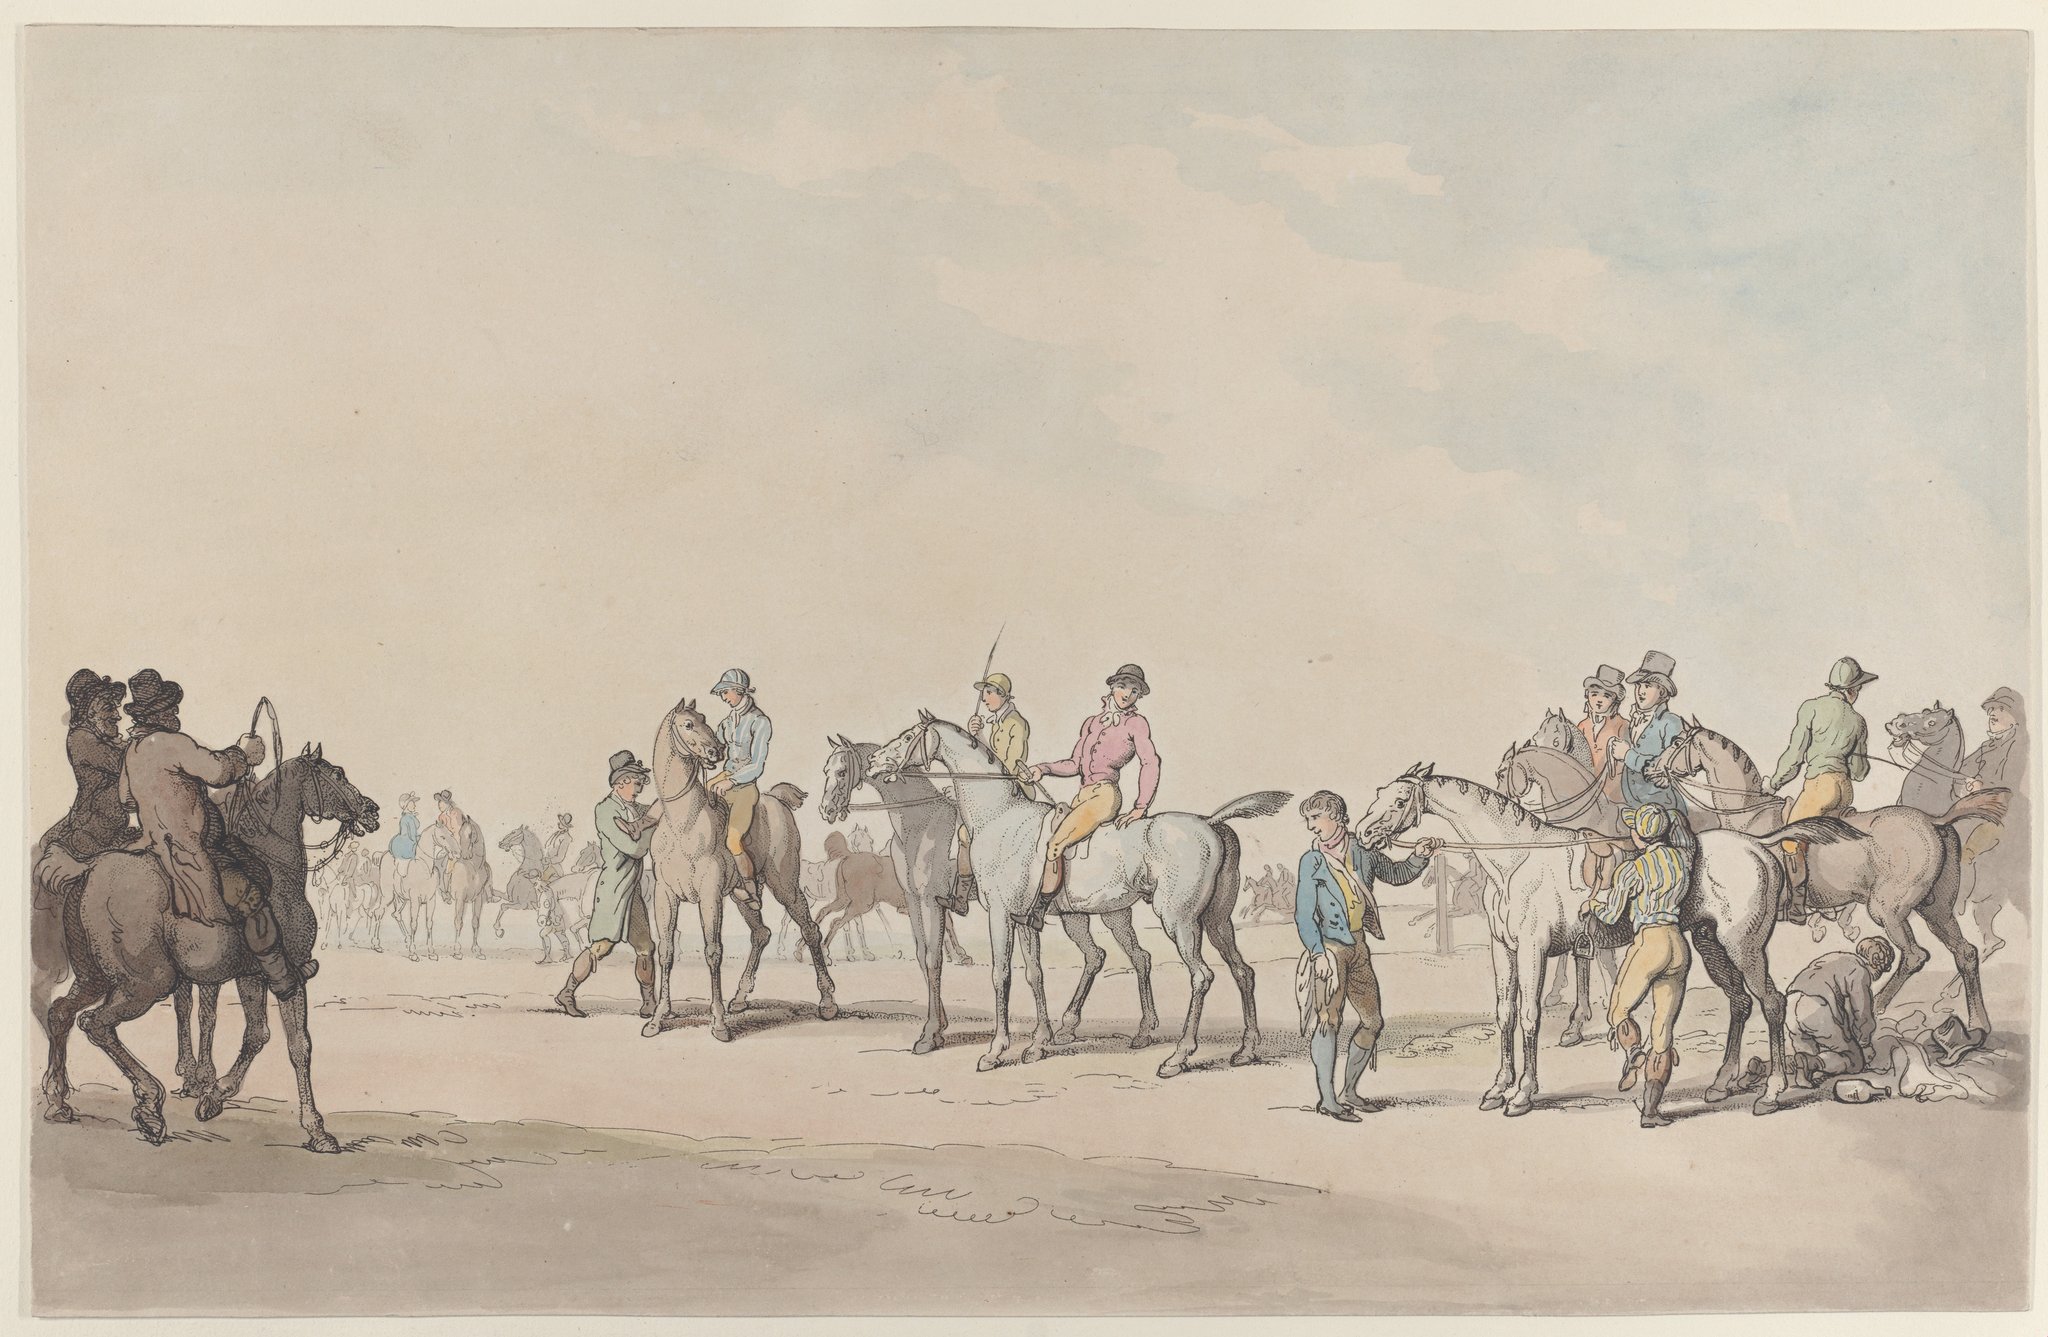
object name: print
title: Preparing for the Race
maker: thomas rowlandson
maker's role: artist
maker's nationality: british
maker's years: 1757-1827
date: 1804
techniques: etching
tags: men,horses,jockeys